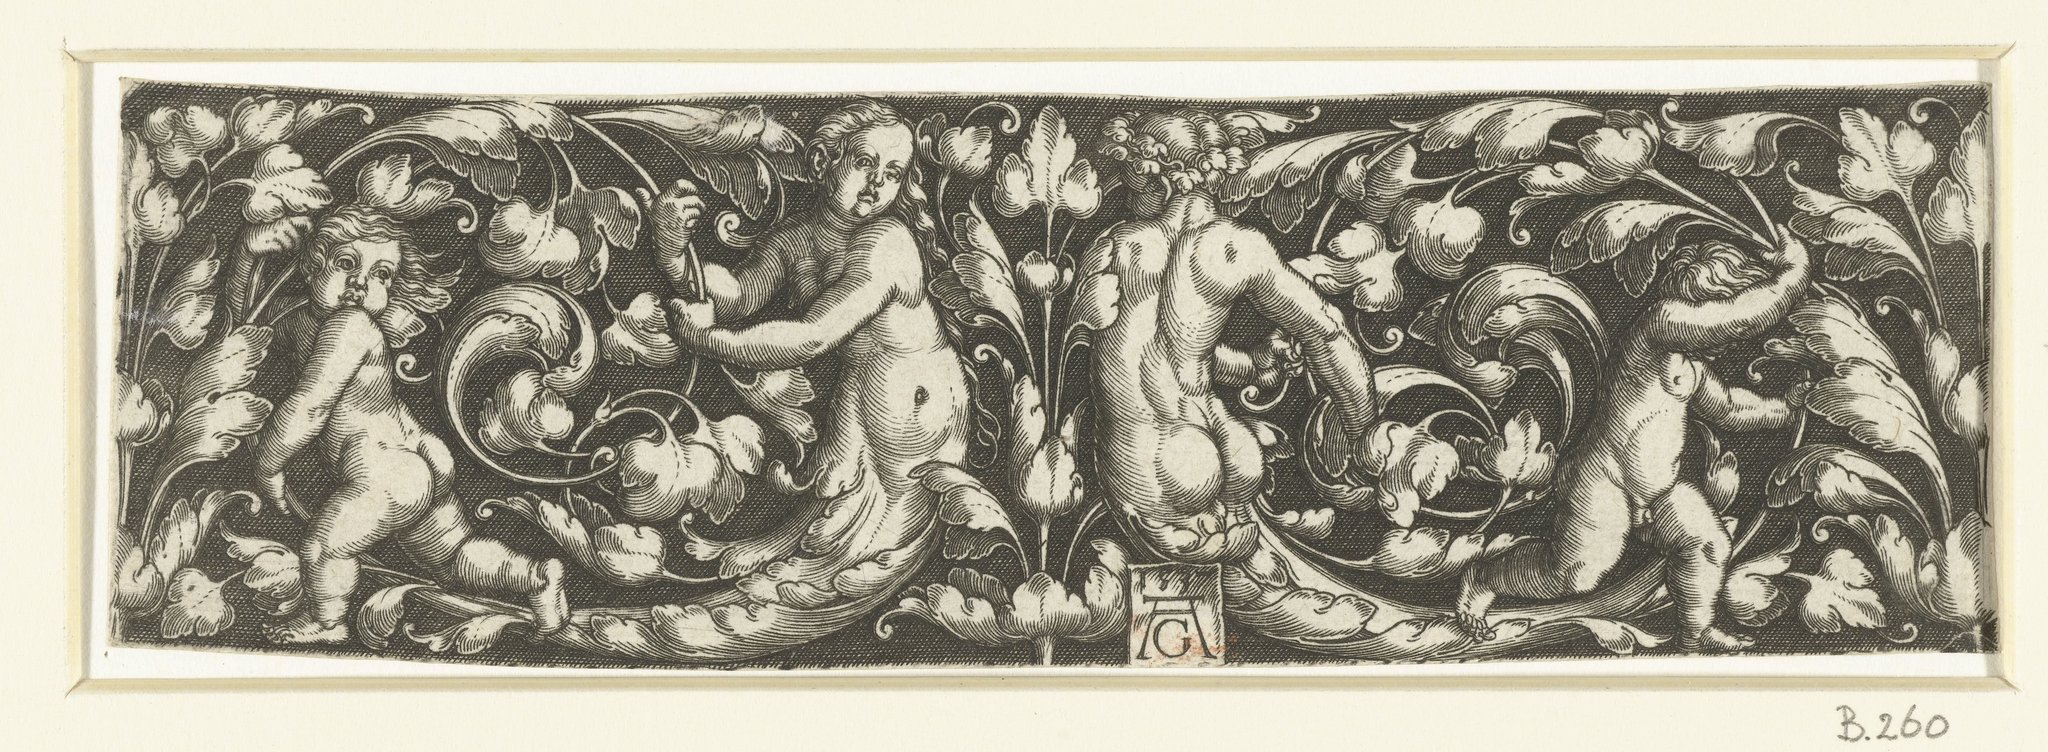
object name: print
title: Fries met bladranken en figuren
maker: heinrich aldegrever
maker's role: draughtsman, print maker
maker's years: 1502-1561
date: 1537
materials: paper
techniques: engraving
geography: germany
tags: anthropomorphic ornament, ornament derived from plant forms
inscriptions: date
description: Fries met een vrouw en een man met onderlichamen van bladranken die zich over het hele blad verspreiden. De man wordt op de rug gezien. Zowel links en rechts bevindt zich een kind.